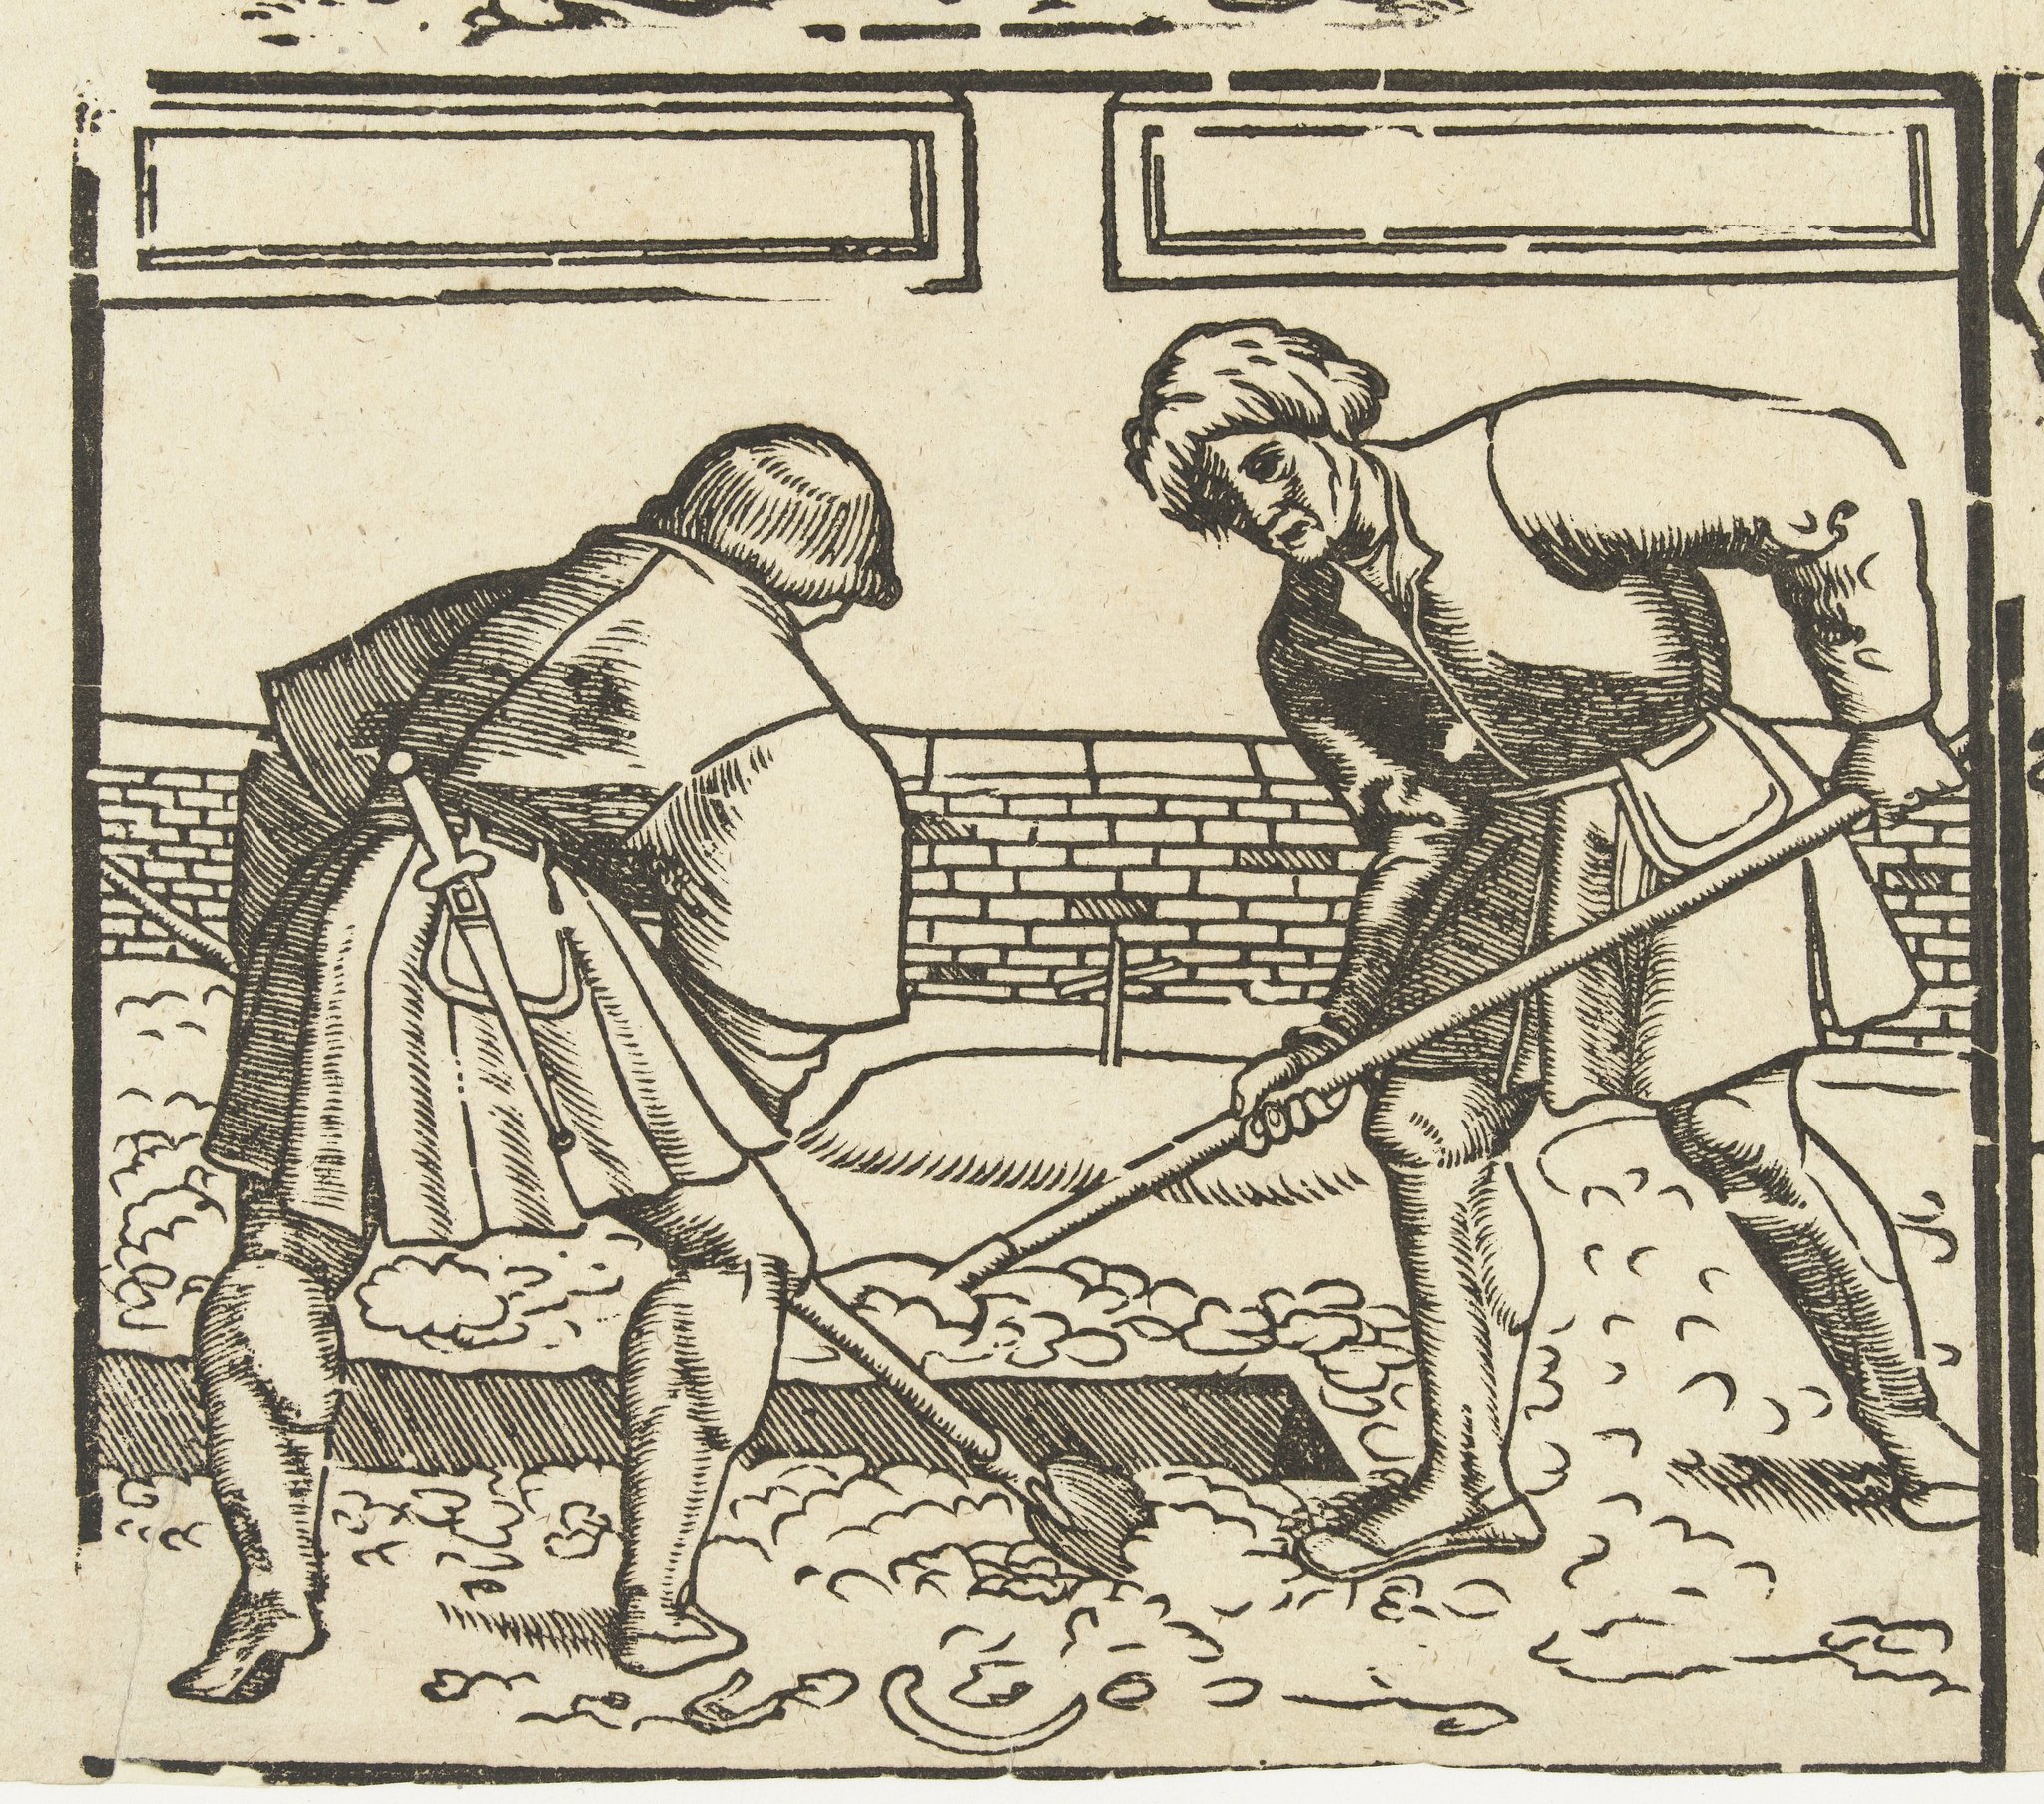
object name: print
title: Twee grafdelvers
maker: Anonymous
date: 1550-1600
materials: paper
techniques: woodcut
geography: low countries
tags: grave digger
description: Gedrukt linksonder op blad met drie andere voostellingen. Twee mannen graven een graf.